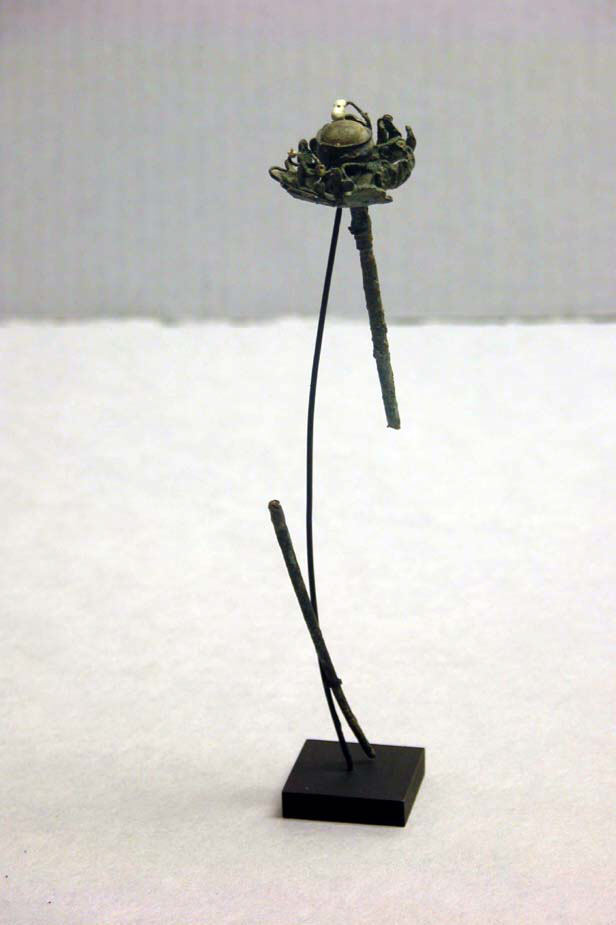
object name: hair ornament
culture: chinese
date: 618-907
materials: silver gilt